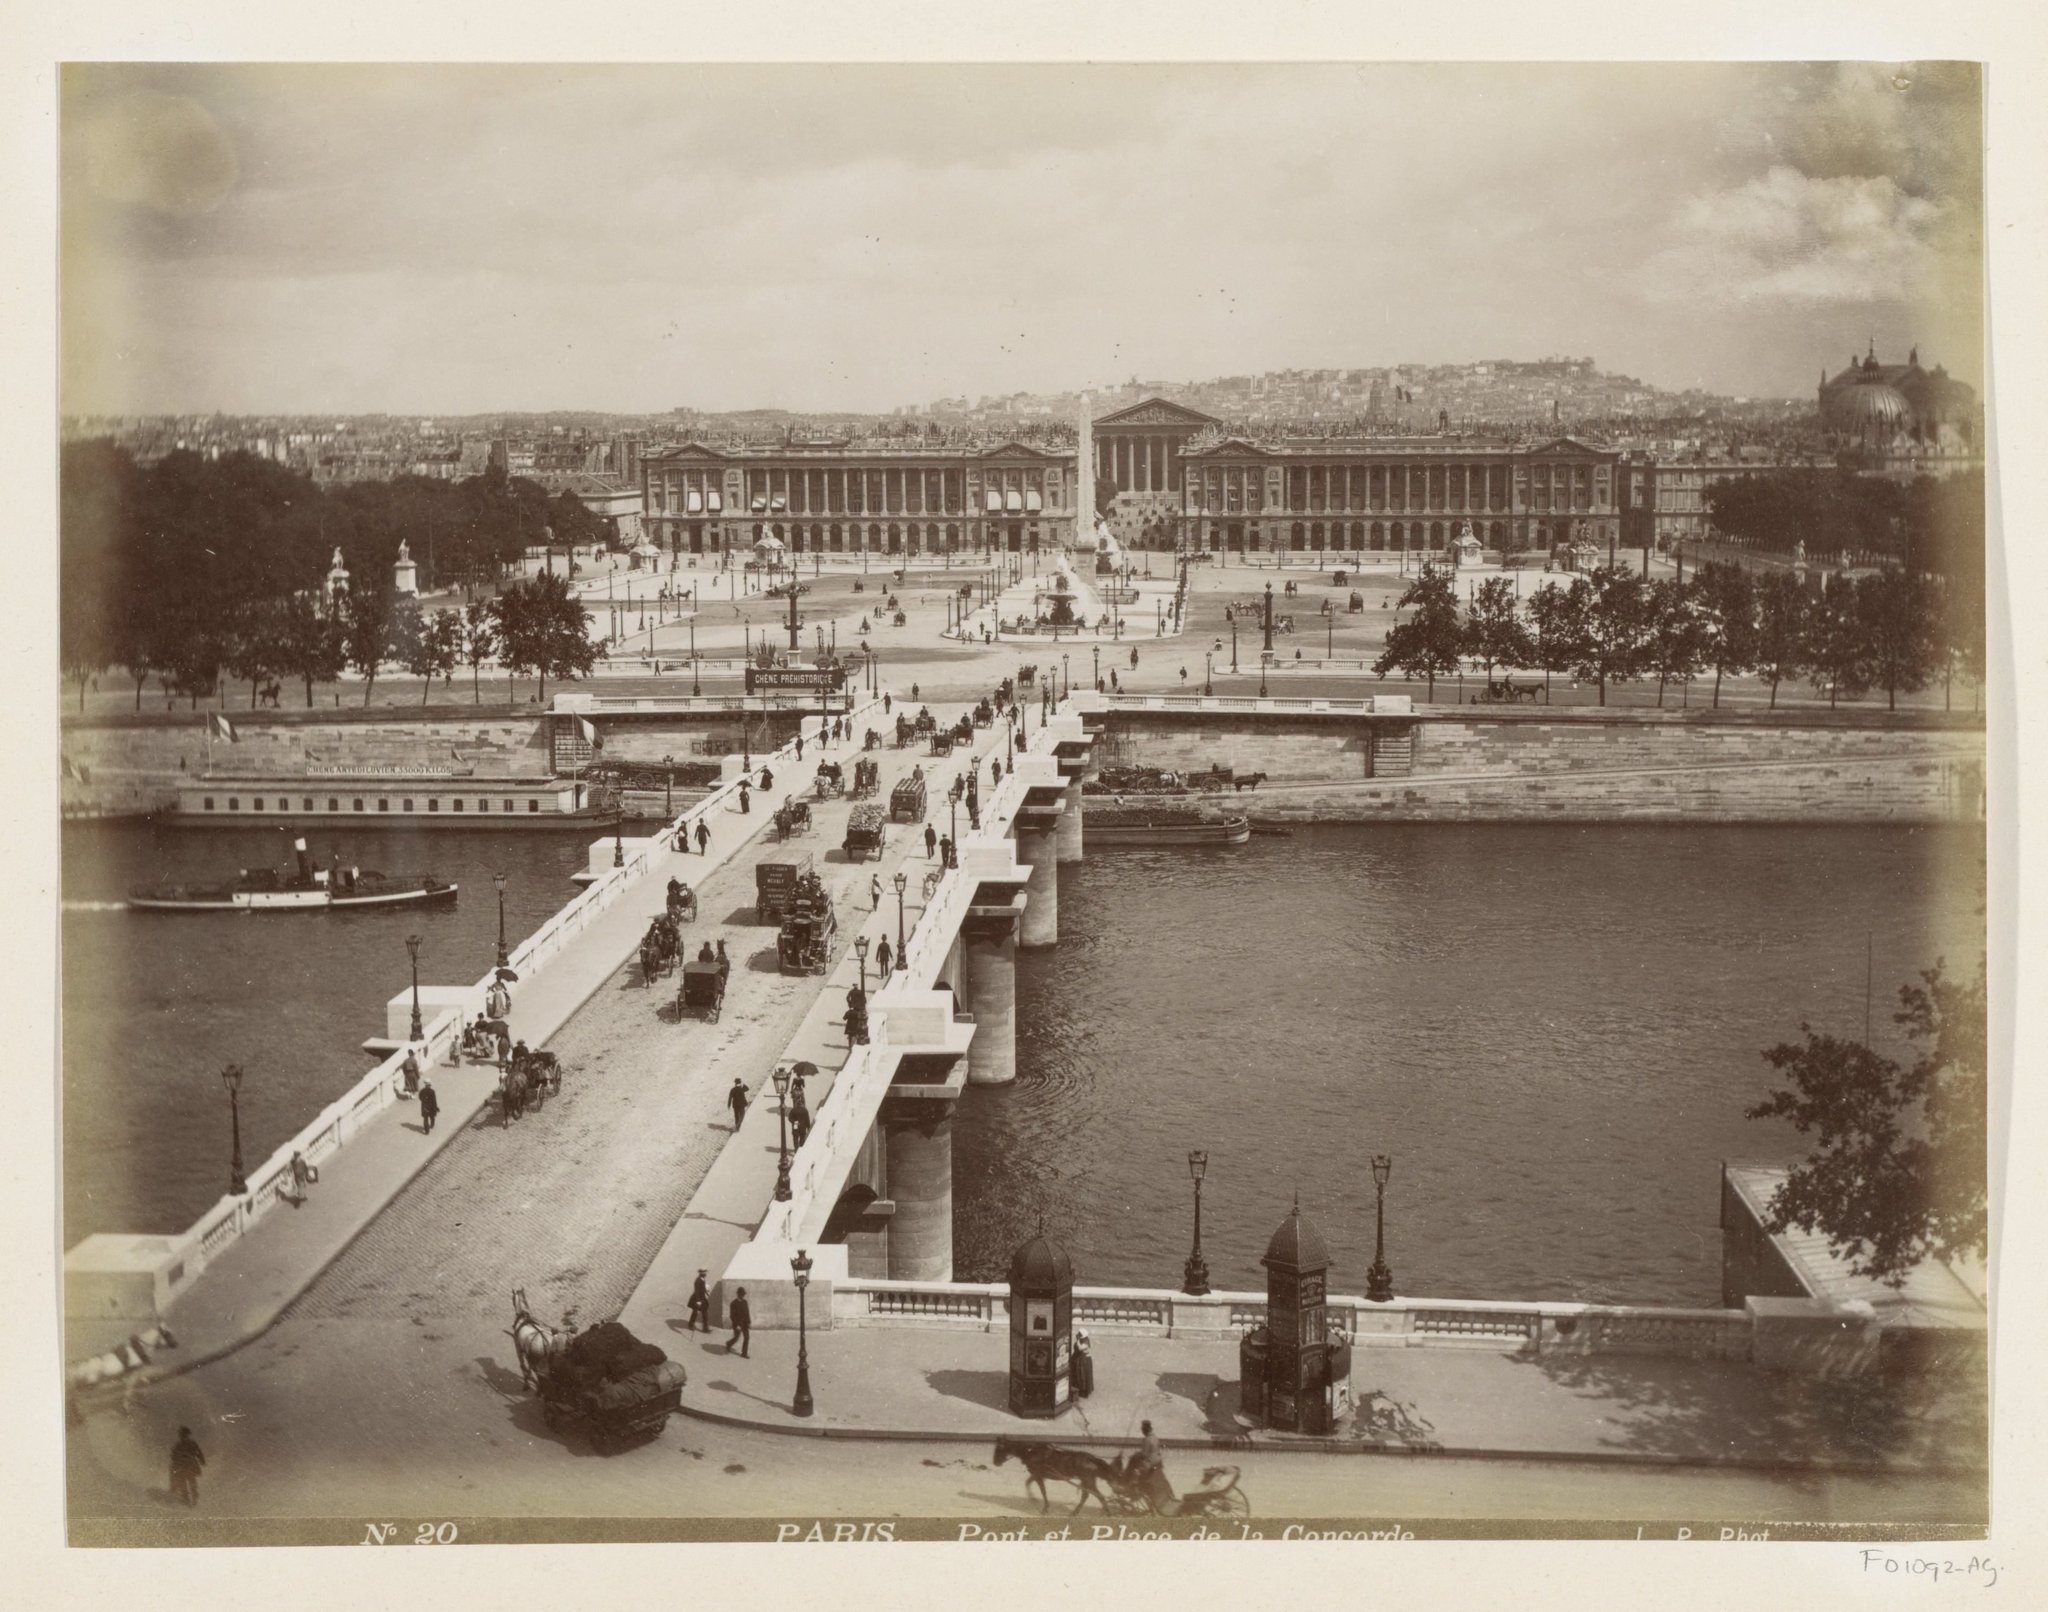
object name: photograph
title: Pont en Place de la Concorde in Parijs, gezien vanaf het Huis van Afgevaardigden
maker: louis antoine pamard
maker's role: fotograaf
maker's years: 1840-1893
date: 1880-1900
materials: cardboard, paper, photographic support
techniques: albumen print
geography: paris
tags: bridge in city across river, canal, etc., square, place, circus, etc. (+ city(-scape) with figures, staffage)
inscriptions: negative number: ‘20’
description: Onderdeel van Reisalbum met foto's van bezienswaardigheden in België en Frankrijk.